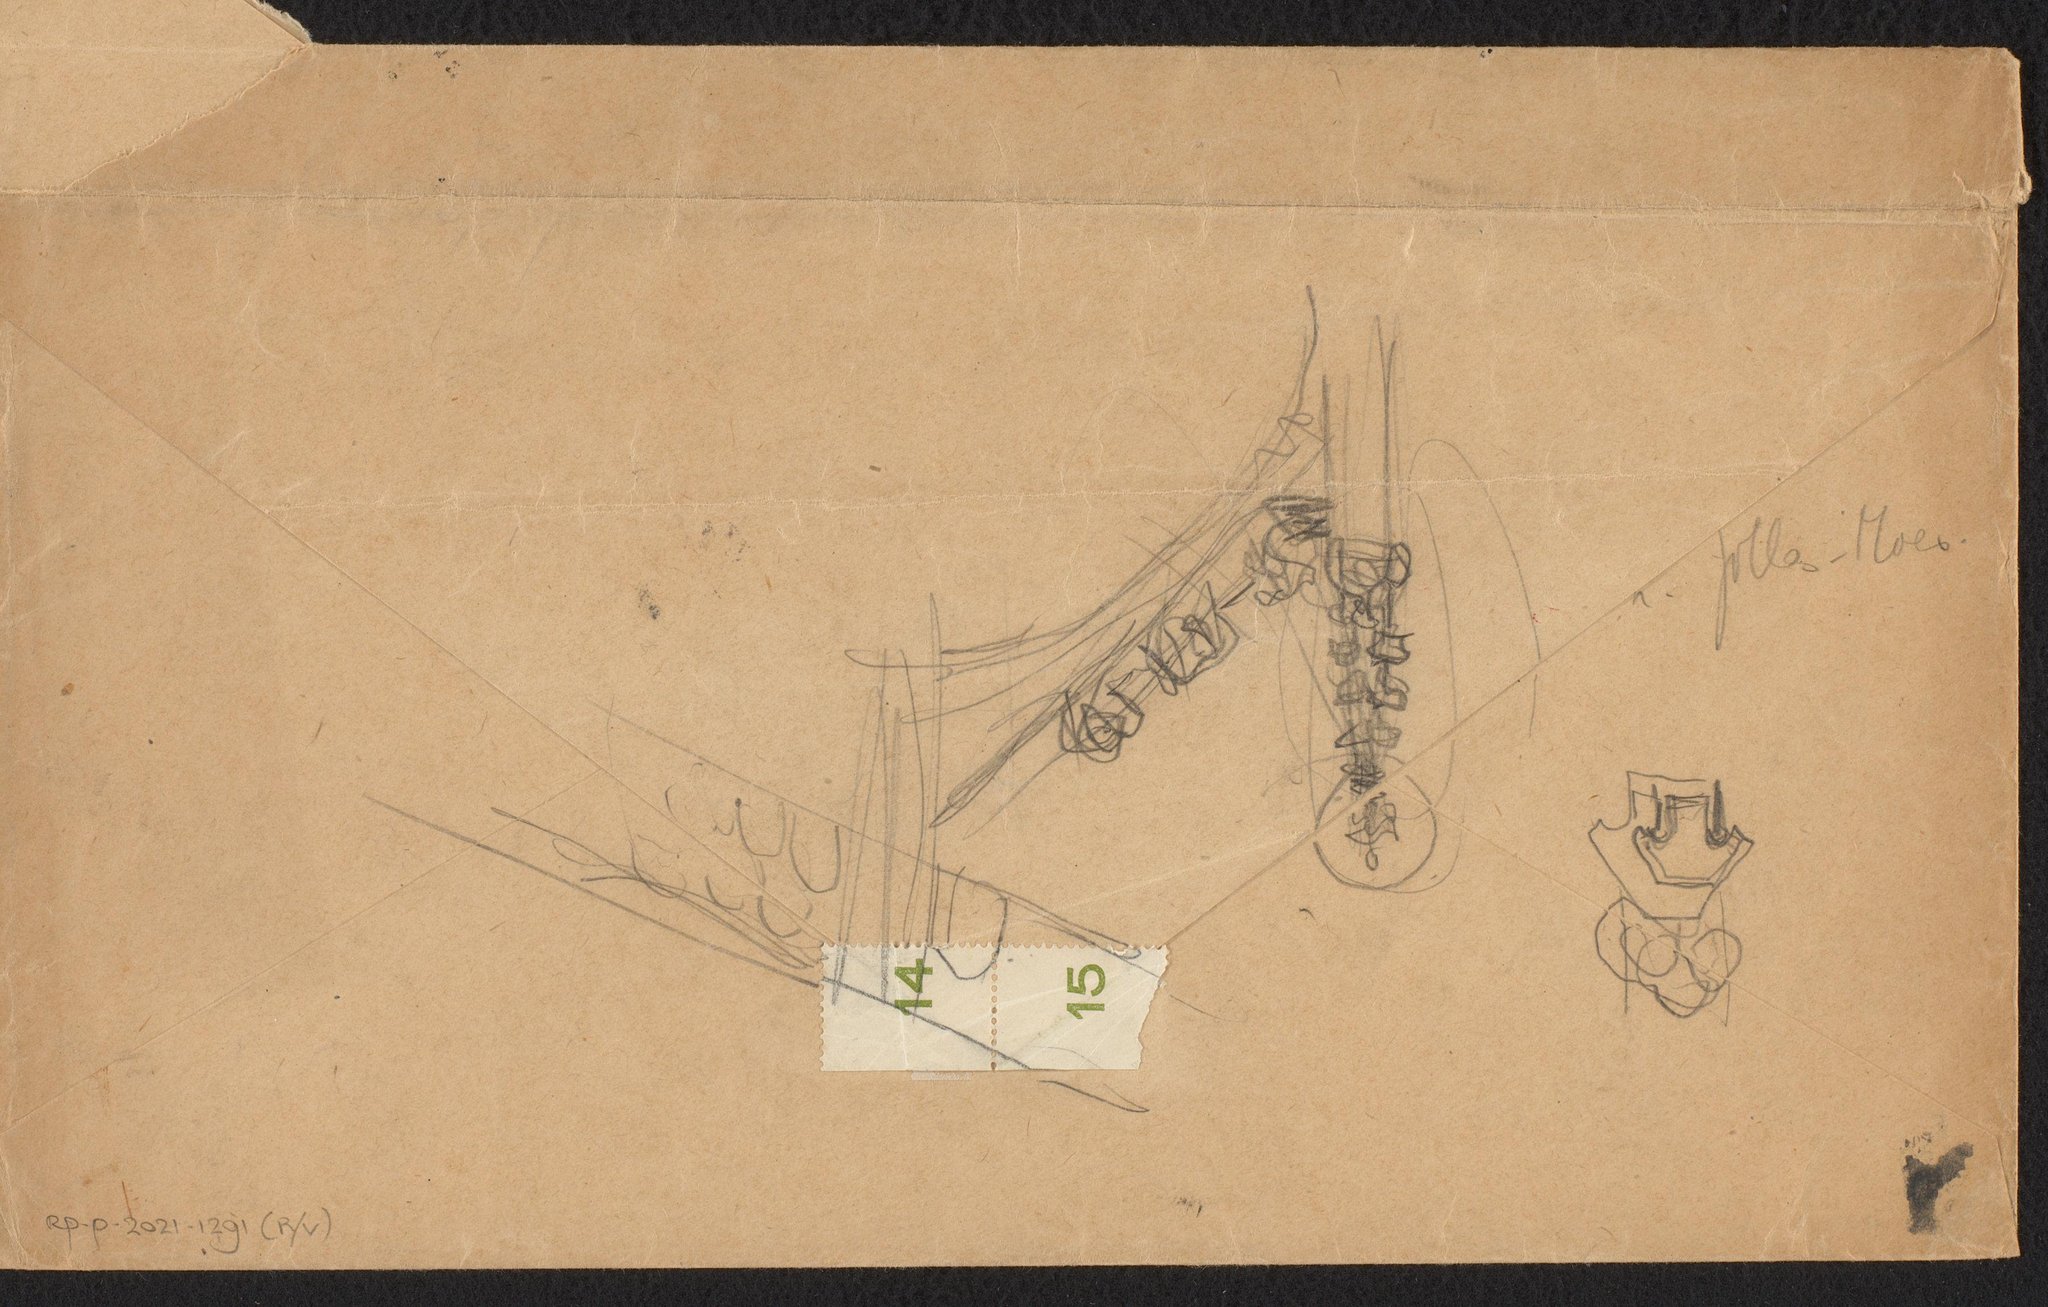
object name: envelope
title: Envelop met architectonische schets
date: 1899-1923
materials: paper, pencil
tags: arch, archivolt ~ architecture, letter, envelope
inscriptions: seal, inscription: ‘Geschenk / mevr. Jolles-Moes’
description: Envelop met detailschets van een luchtboog met pinakel en decoratieve elementen.